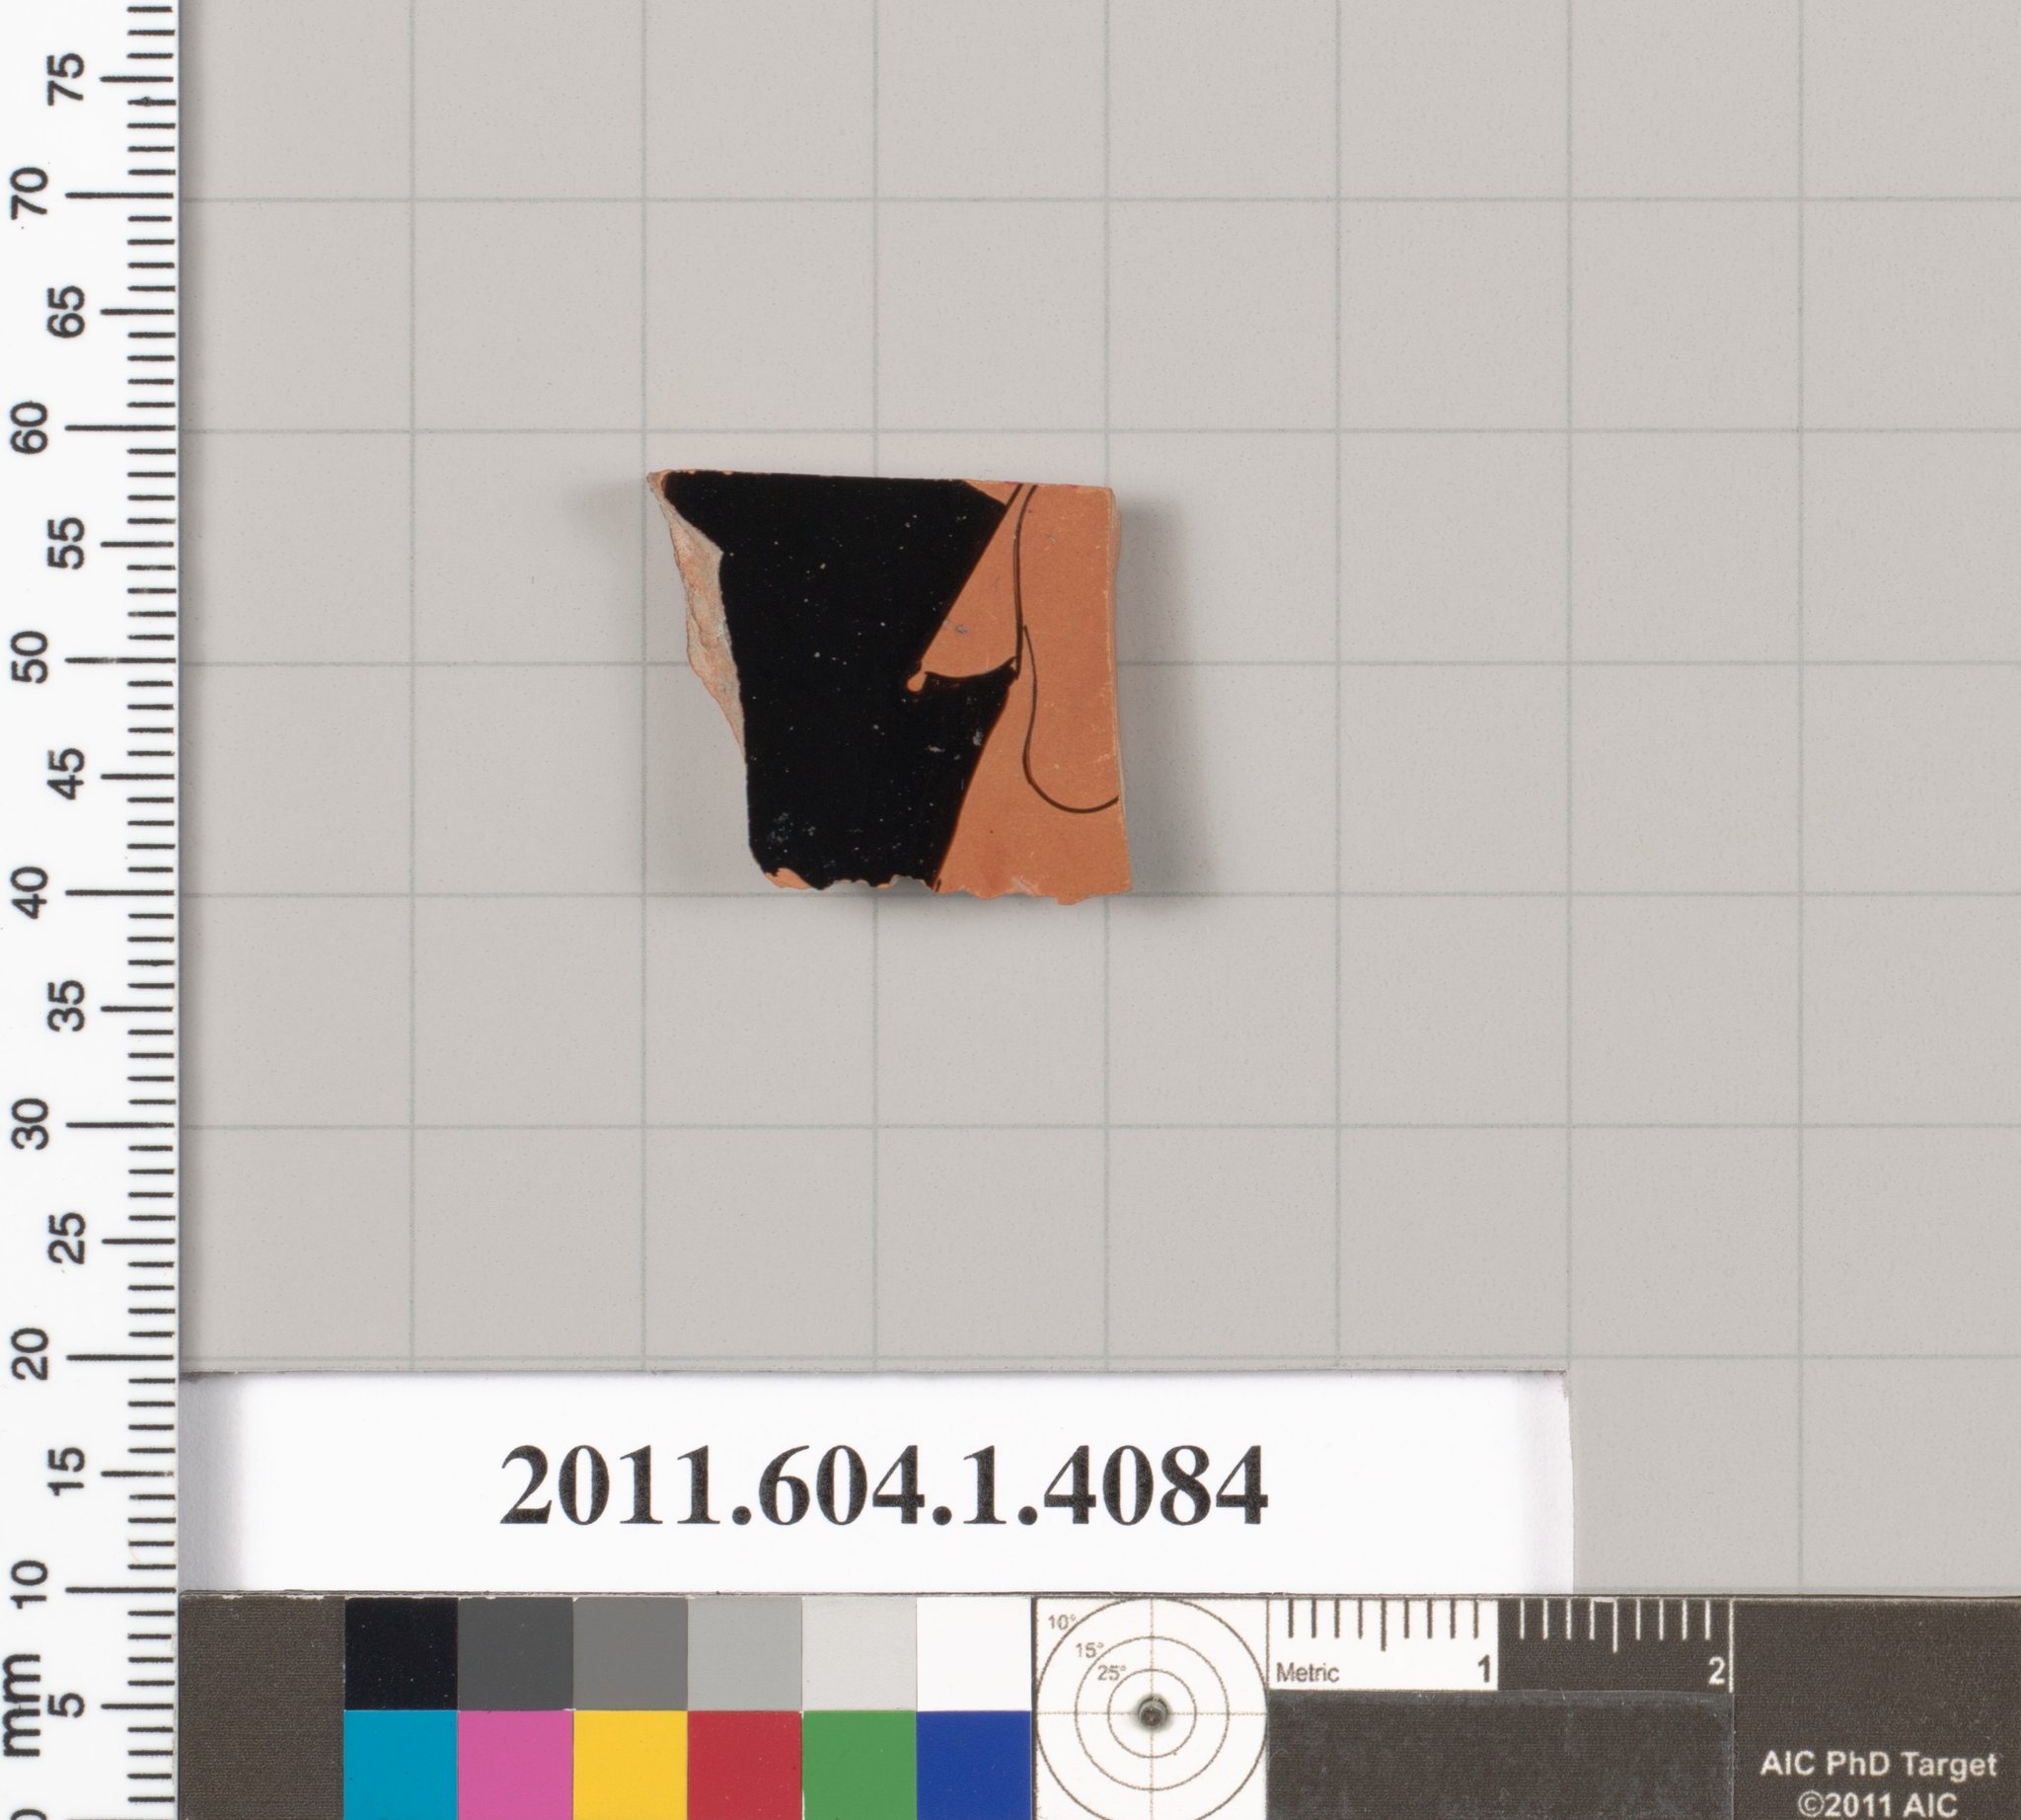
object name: kylix fragment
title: Terracotta fragment of a kylix (drinking cup)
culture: greek, attic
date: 500-480 BCE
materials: terracotta